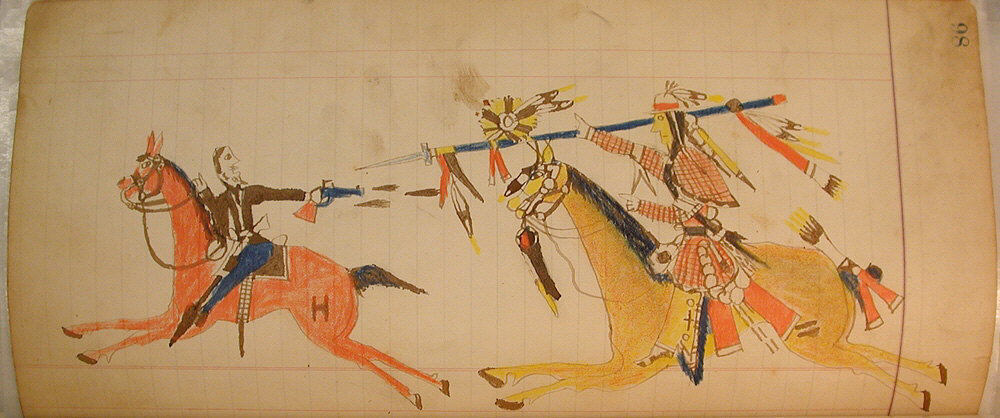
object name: drawing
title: Maffet Ledger: Drawing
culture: cheyenne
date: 1874-1881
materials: crayon, graphite, paper, watercolor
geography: united states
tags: battles,men,horses